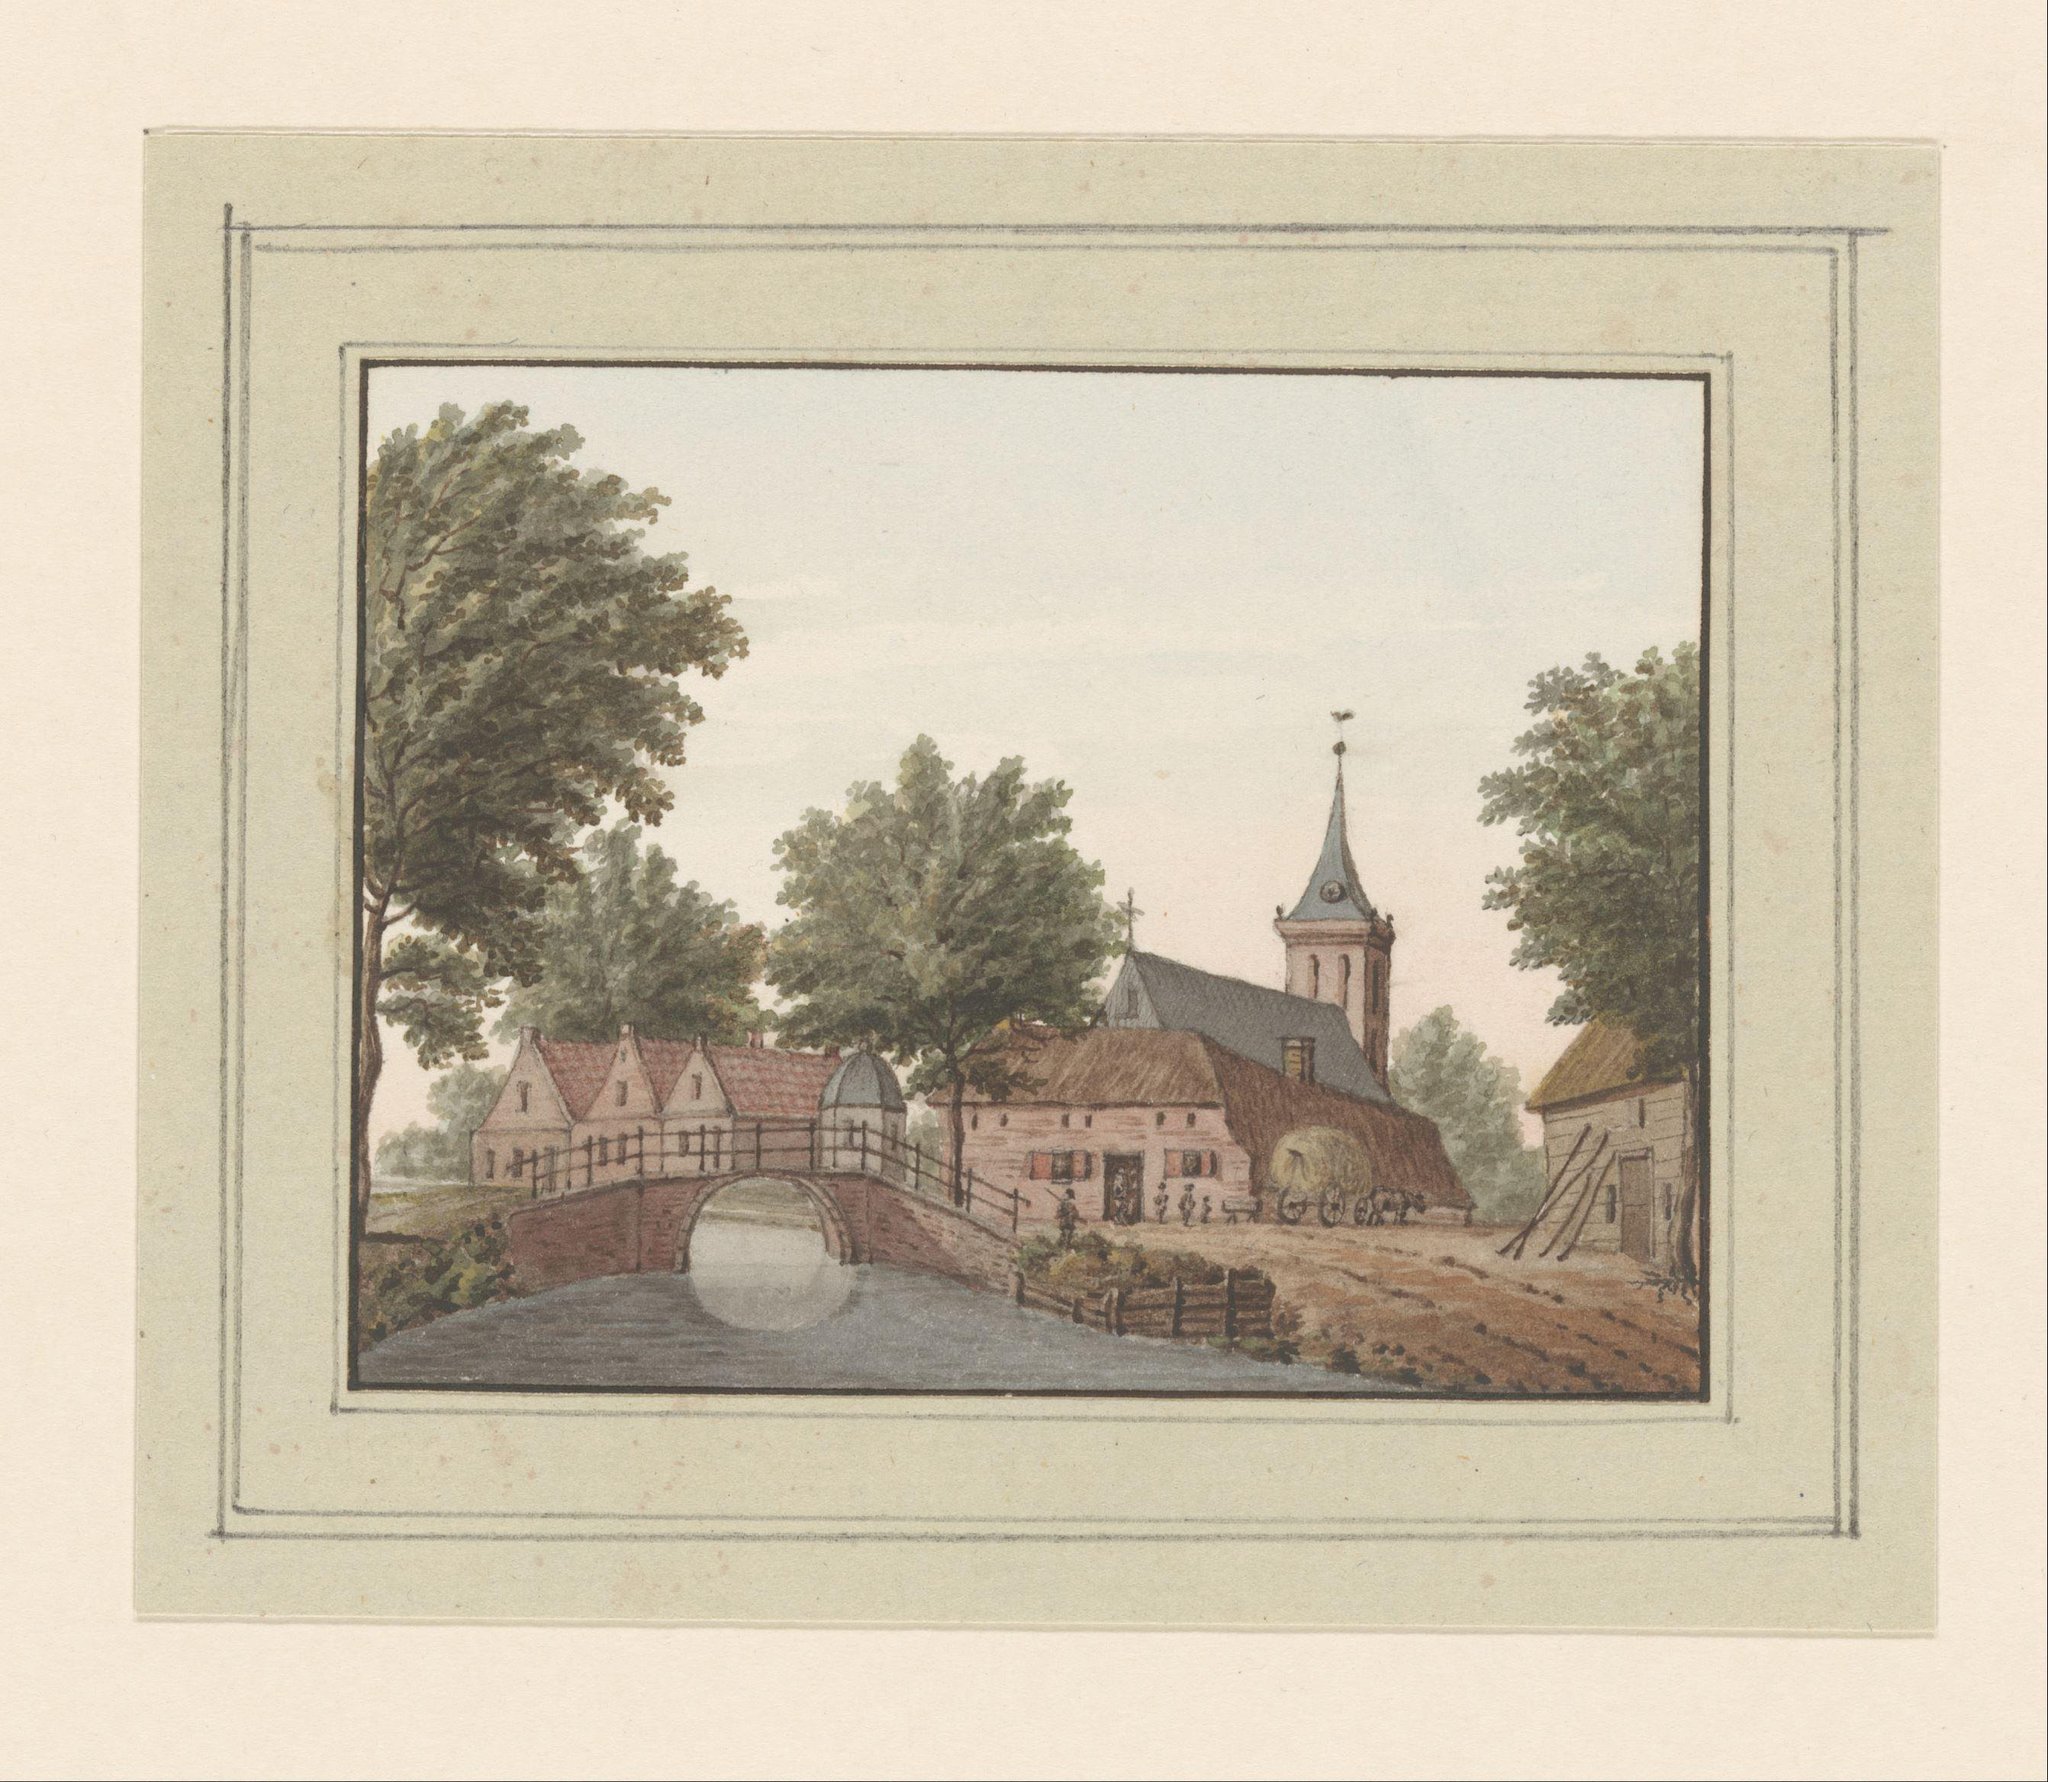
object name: drawing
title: Gezicht op Nieuwland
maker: Anonymous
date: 1750-1850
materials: ink, paper, watercolor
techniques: aquarelle, drawing, pen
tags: church (exterior), bridge in village across river, canal, etc.